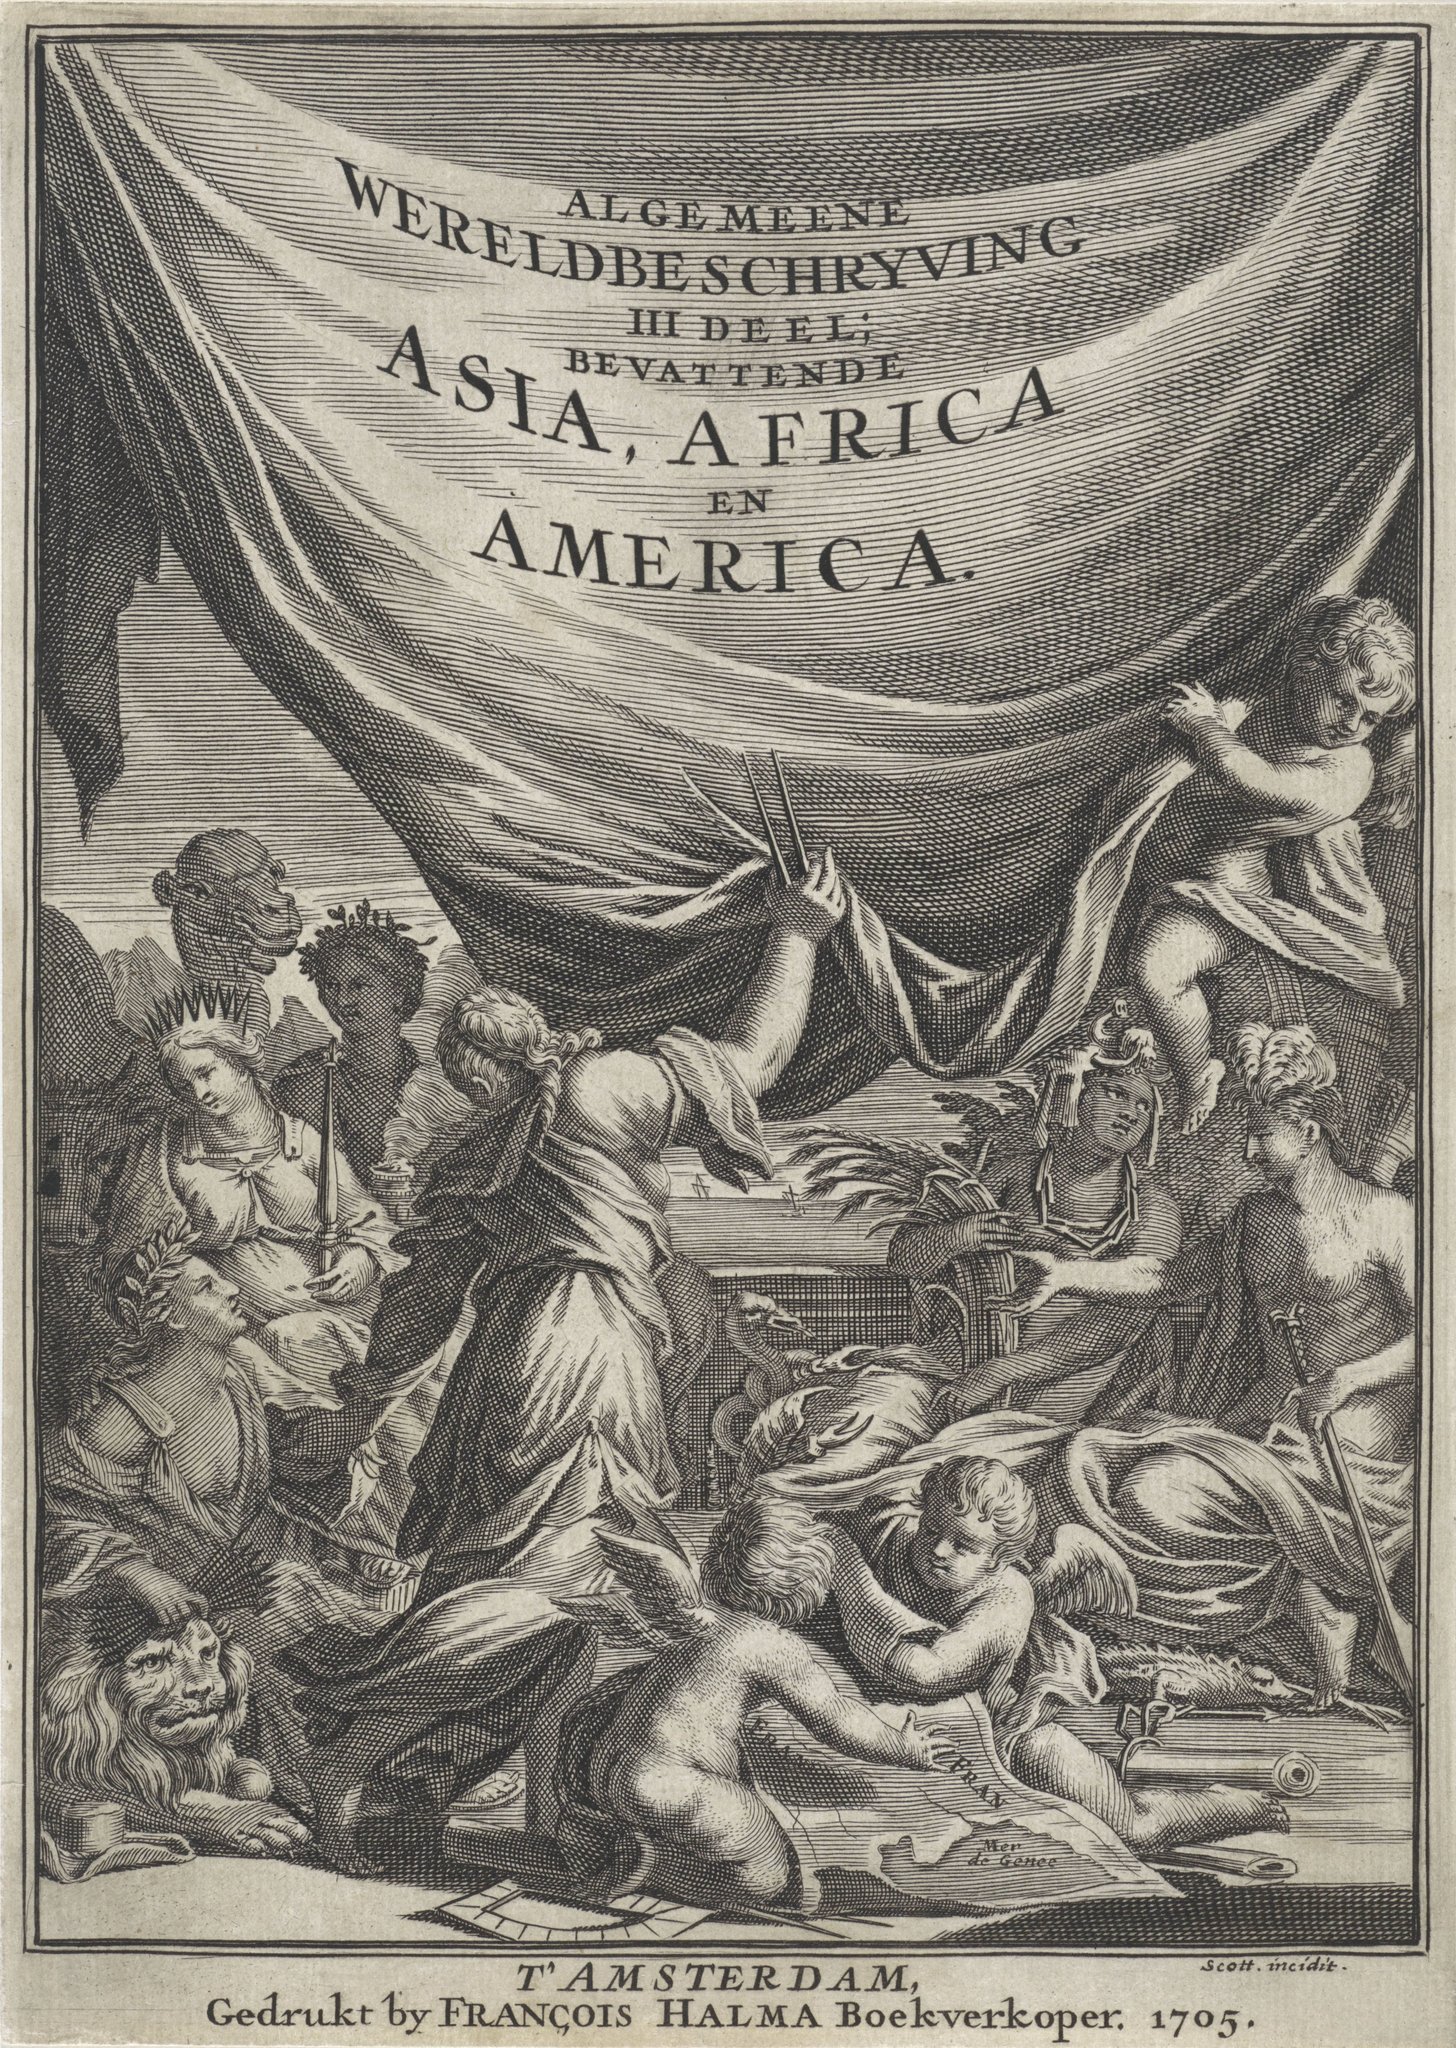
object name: titelblad, titelpagina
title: Titelpagina voor: F. Halma, Algemeene Wereldbeschryving (...), 1705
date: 1705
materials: paper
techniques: engraving, etching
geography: amsterdam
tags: maps of separate countries or regions, asia represented allegorically; 'asia' (ripa), africa represented allegorically; 'africa' (ripa), america represented allegorically; 'america' (ripa)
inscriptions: collector's mark: Lugt 2760, collector's mark: Lugt 2228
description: In het midden een draperie met de titel in het Nederlands. Een figuur houdt de draperie op. Links zit de vrouwelijke personificatie van Afrika, een leeuw aan haar zijde. Daarachter de personificatie van Azië, gevolgd door een kameel. Aan de rechterzijde zit de personificatie van Amerika, met een krokodil aan haar voeten. Ze is vergezeld door een zwarte figuur. Op de voorgrond twee putti bij een kaart van Frankrijk. In de marge het impressum in het Nederlands.